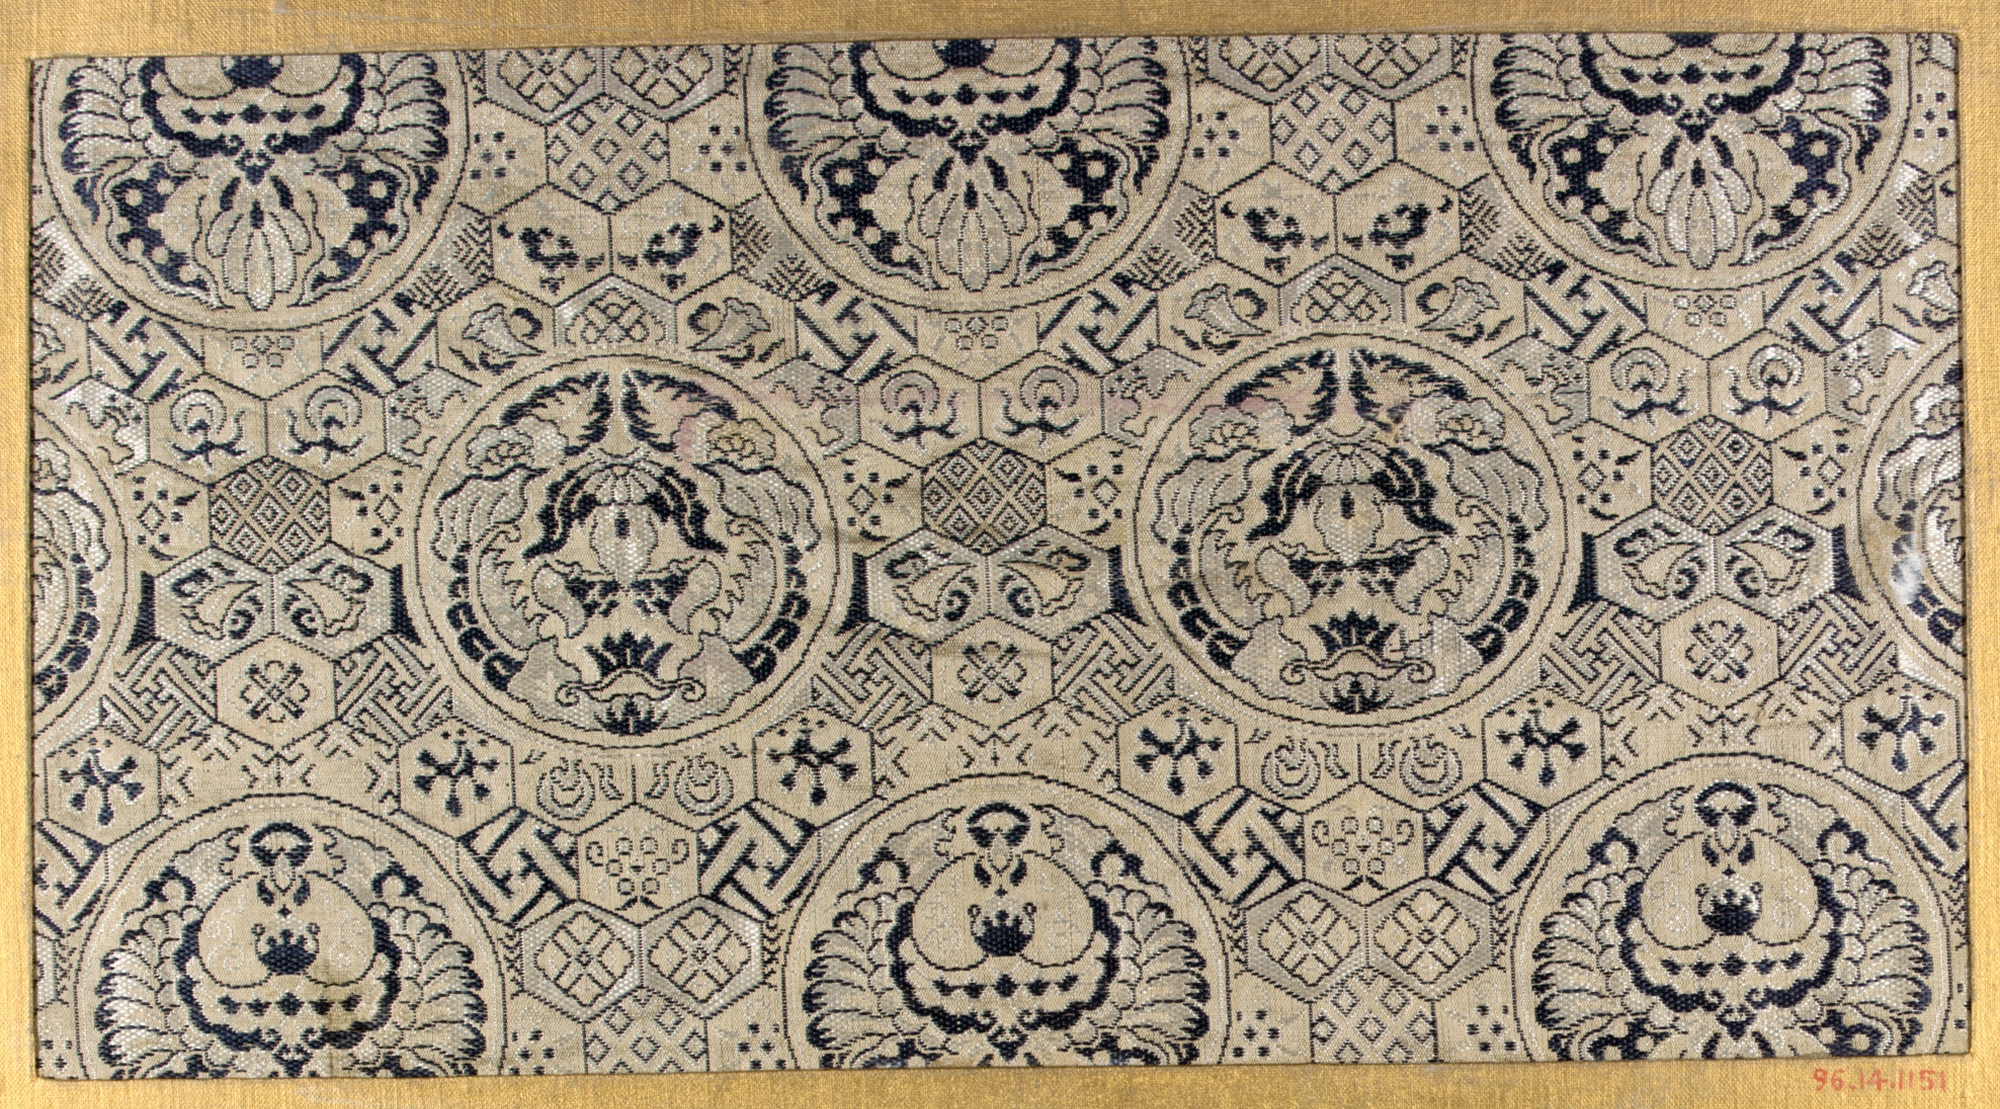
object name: piece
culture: japanese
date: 1701-1900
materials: silk